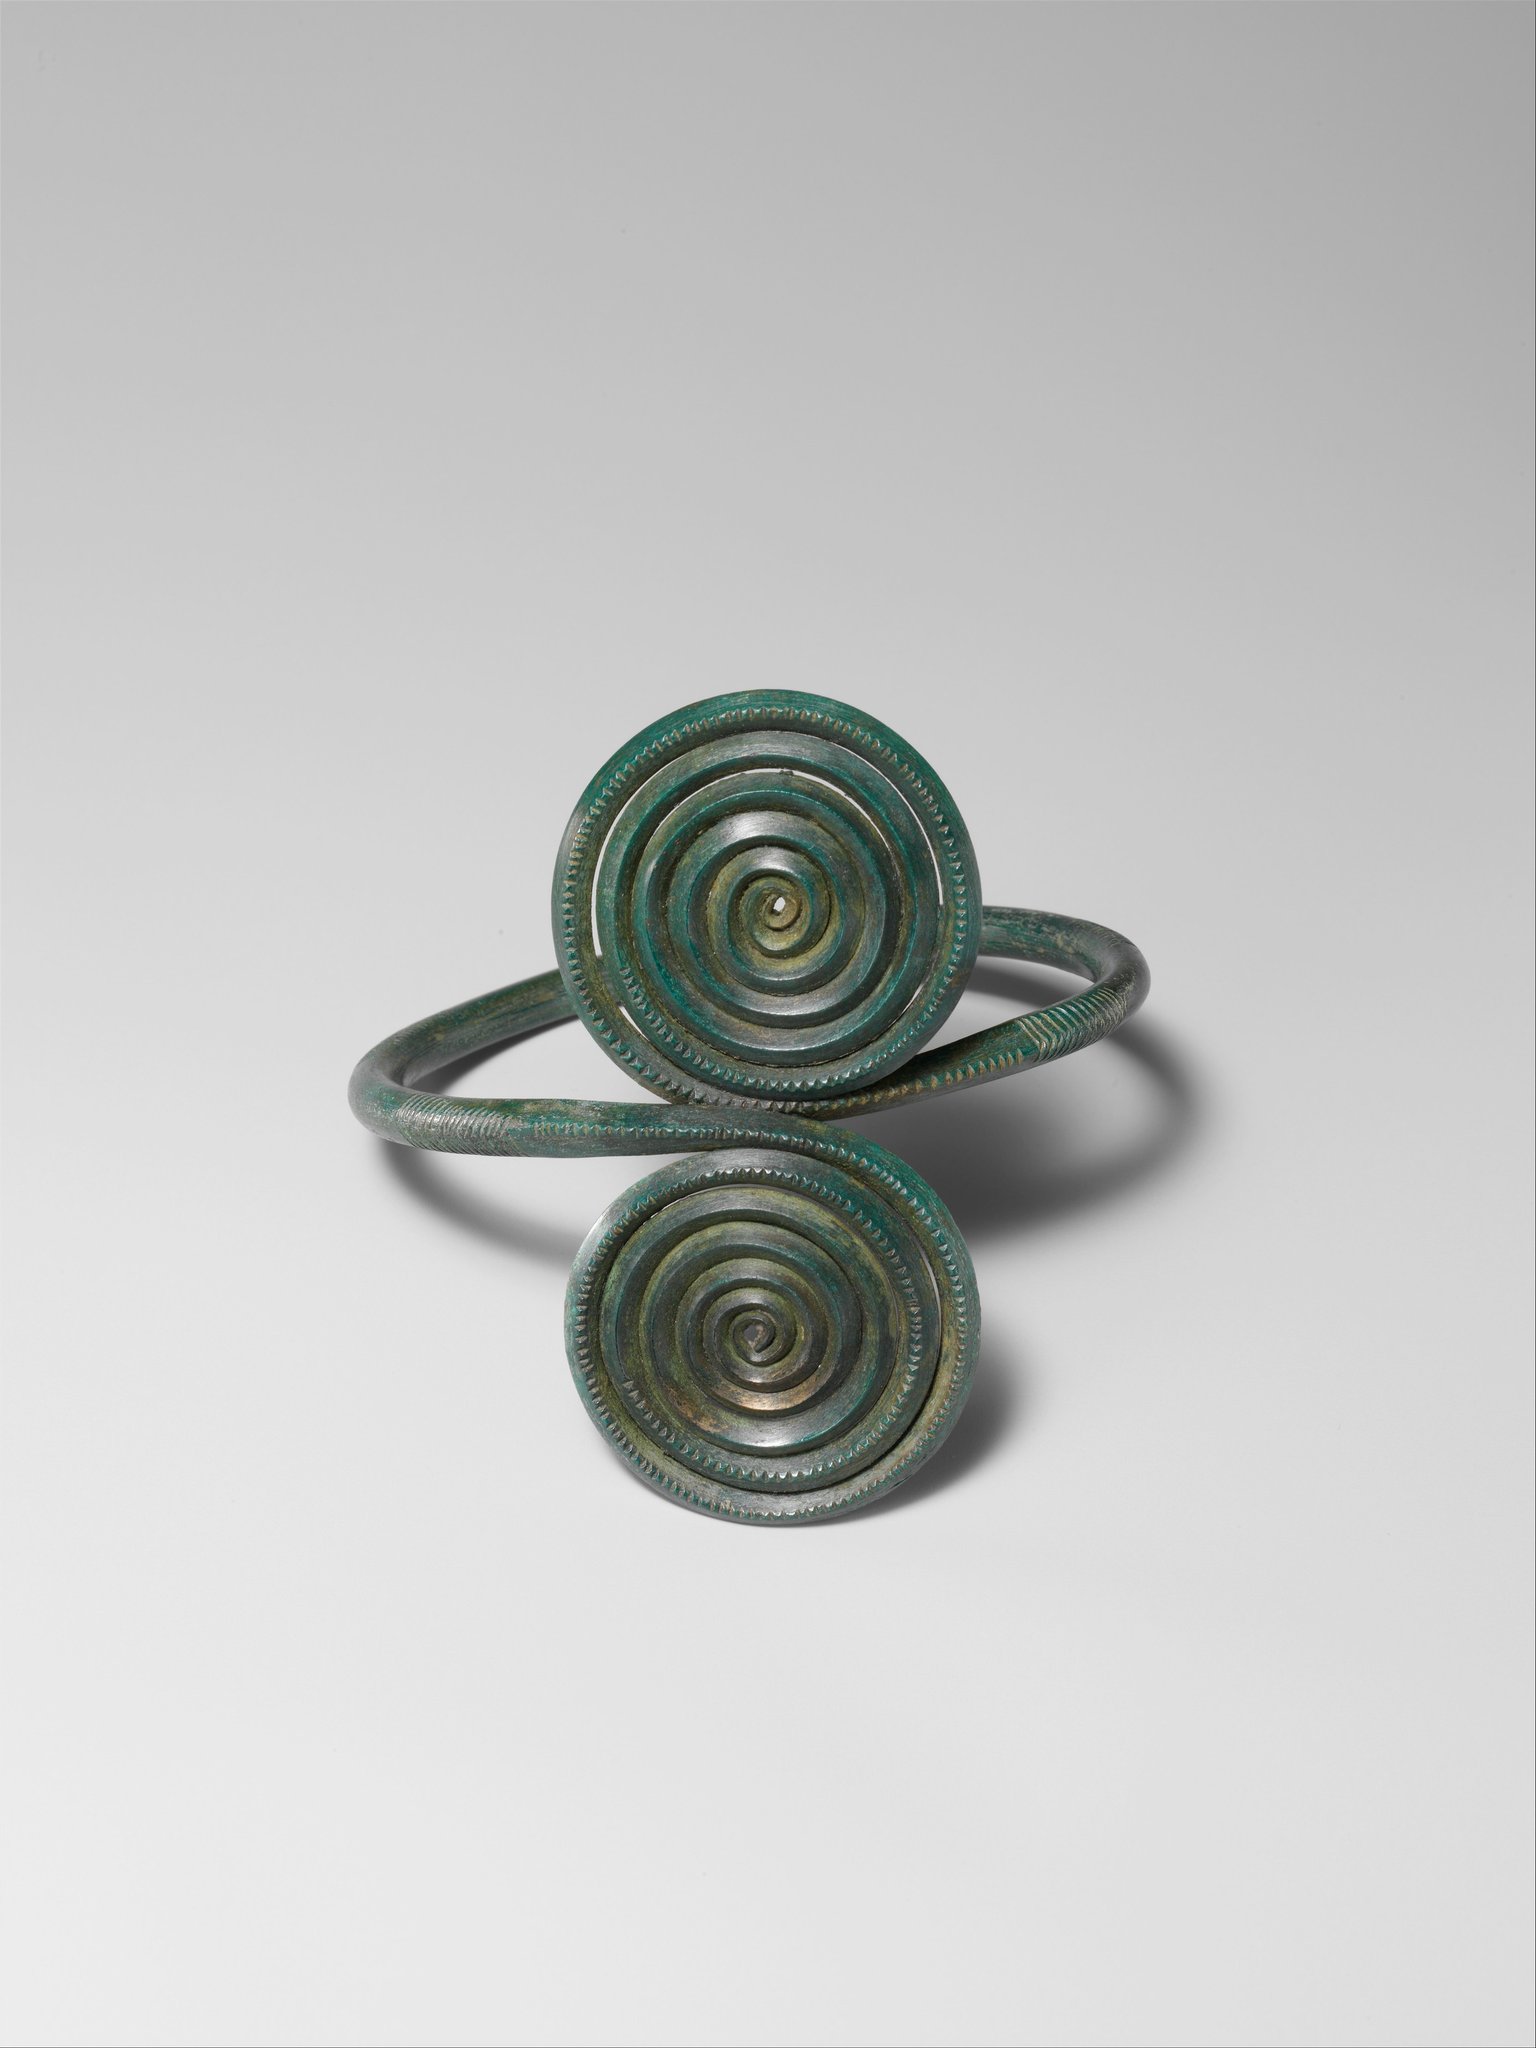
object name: armband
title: Armband with Spirals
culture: european bronze age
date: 1400-1101 BCE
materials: copper alloy